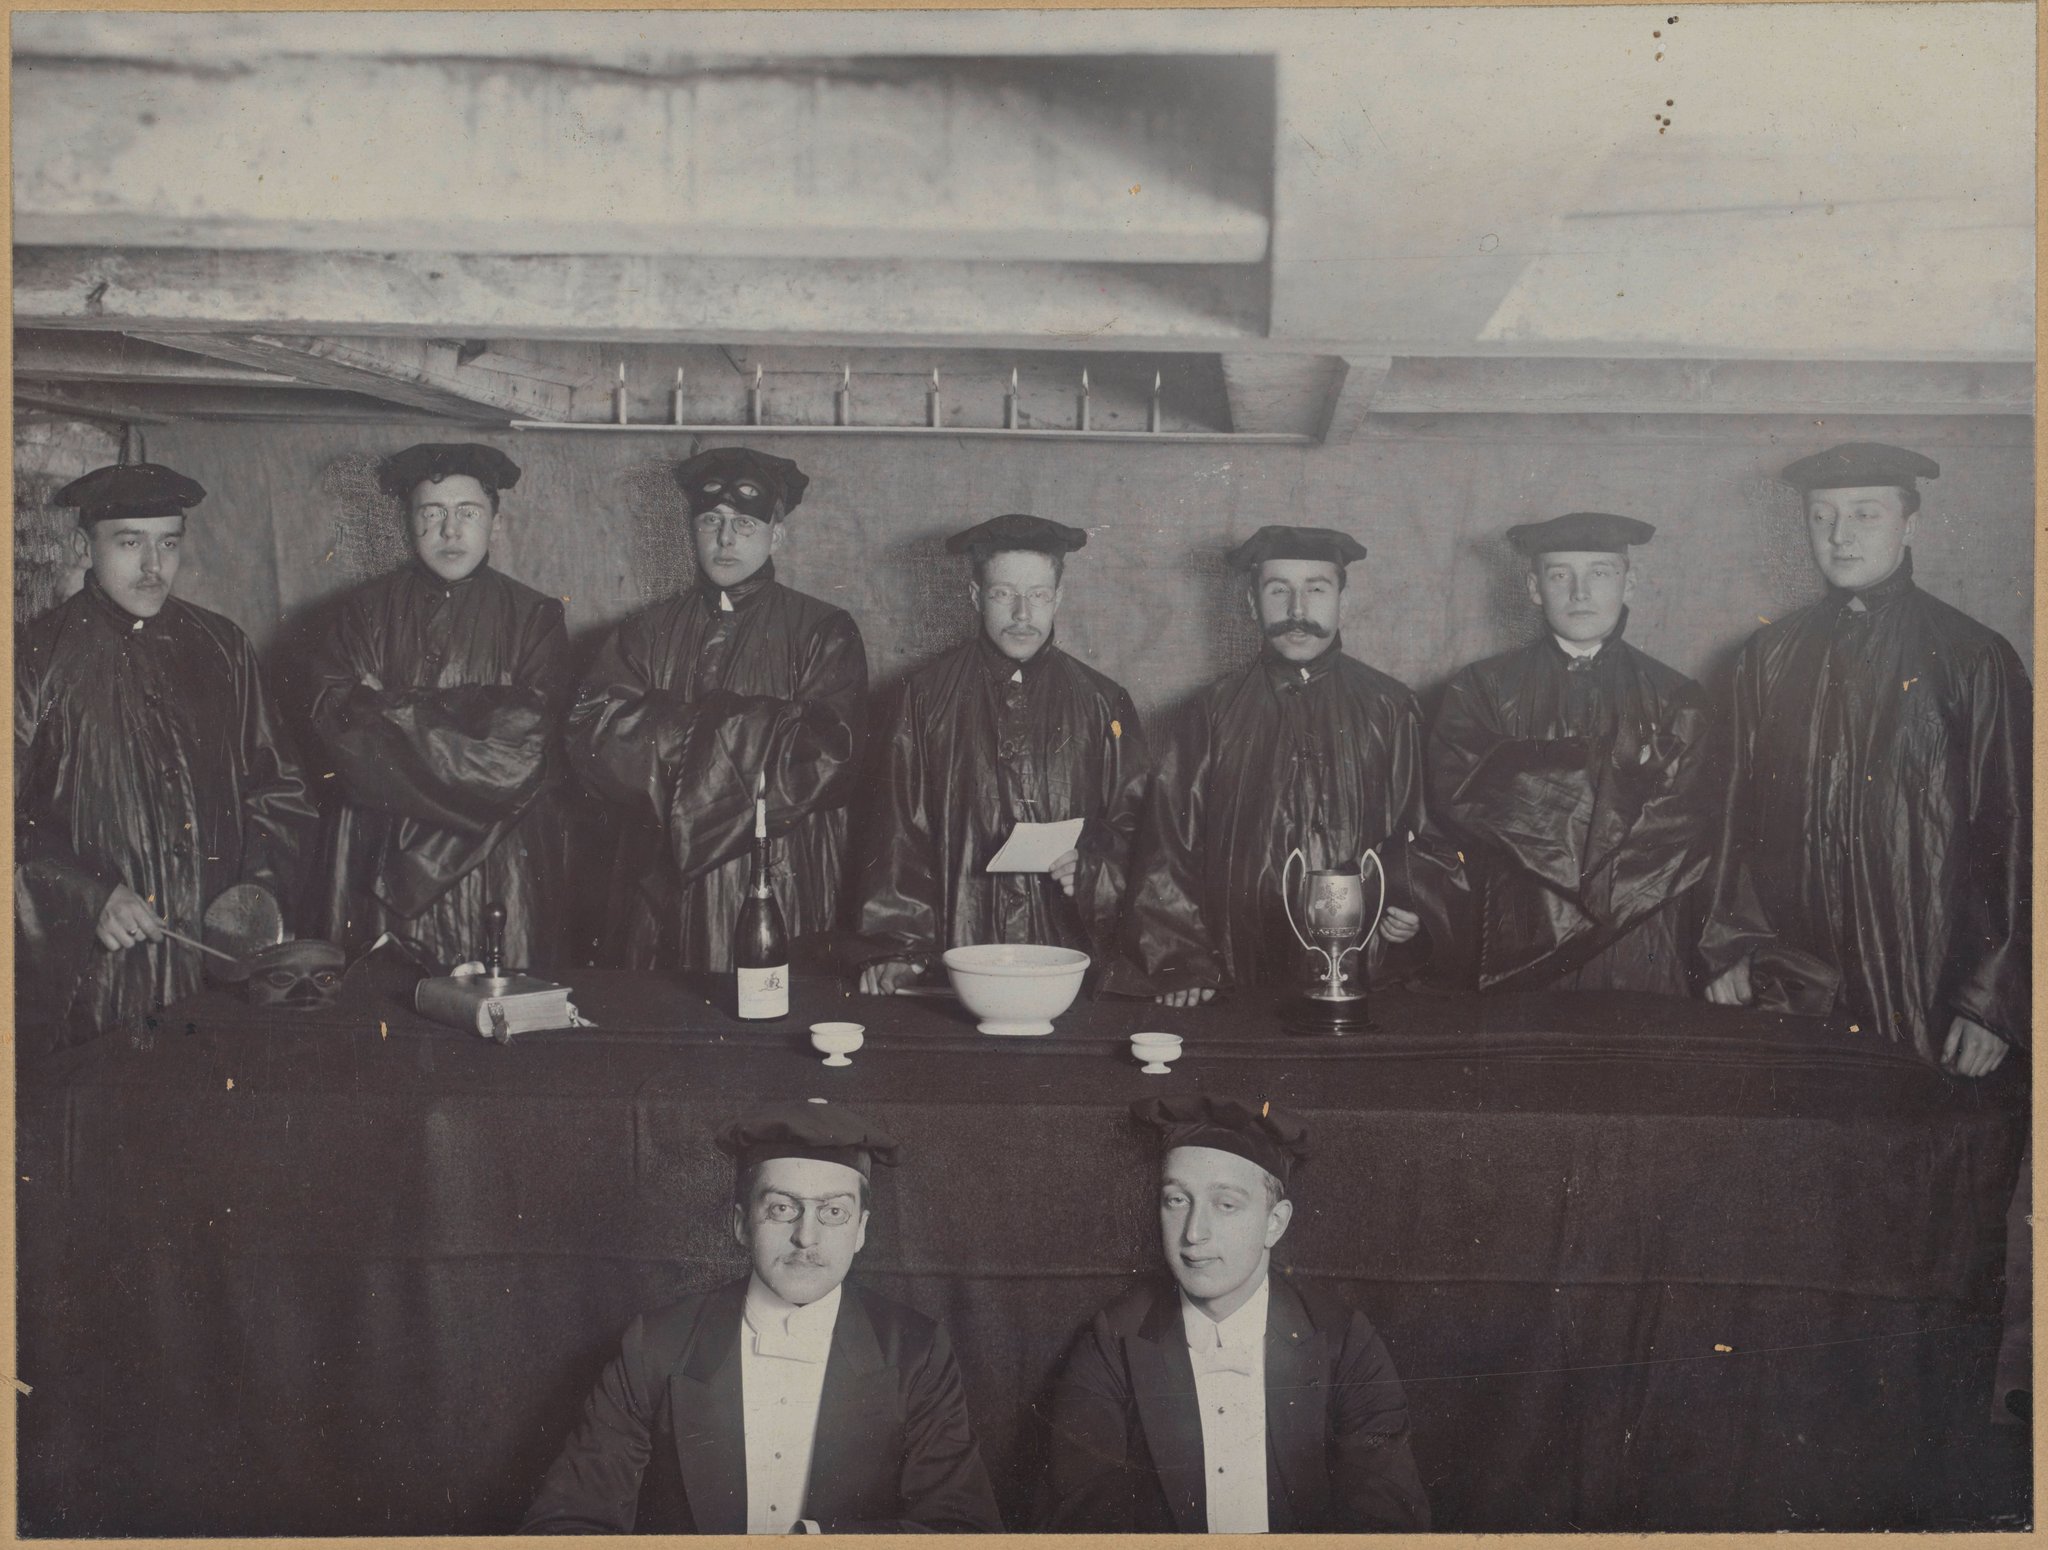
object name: photograph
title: Groepsportret van (vermoedelijk) een studentengenootschap in lange gewaden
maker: nicolaas schuitvlot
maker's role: fotograaf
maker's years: 1859-1947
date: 1895-1910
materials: cardboard, paper, photographic support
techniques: collodion silver print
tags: students' organization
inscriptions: address: ‘Paleisstraat 5 Amsterdam’